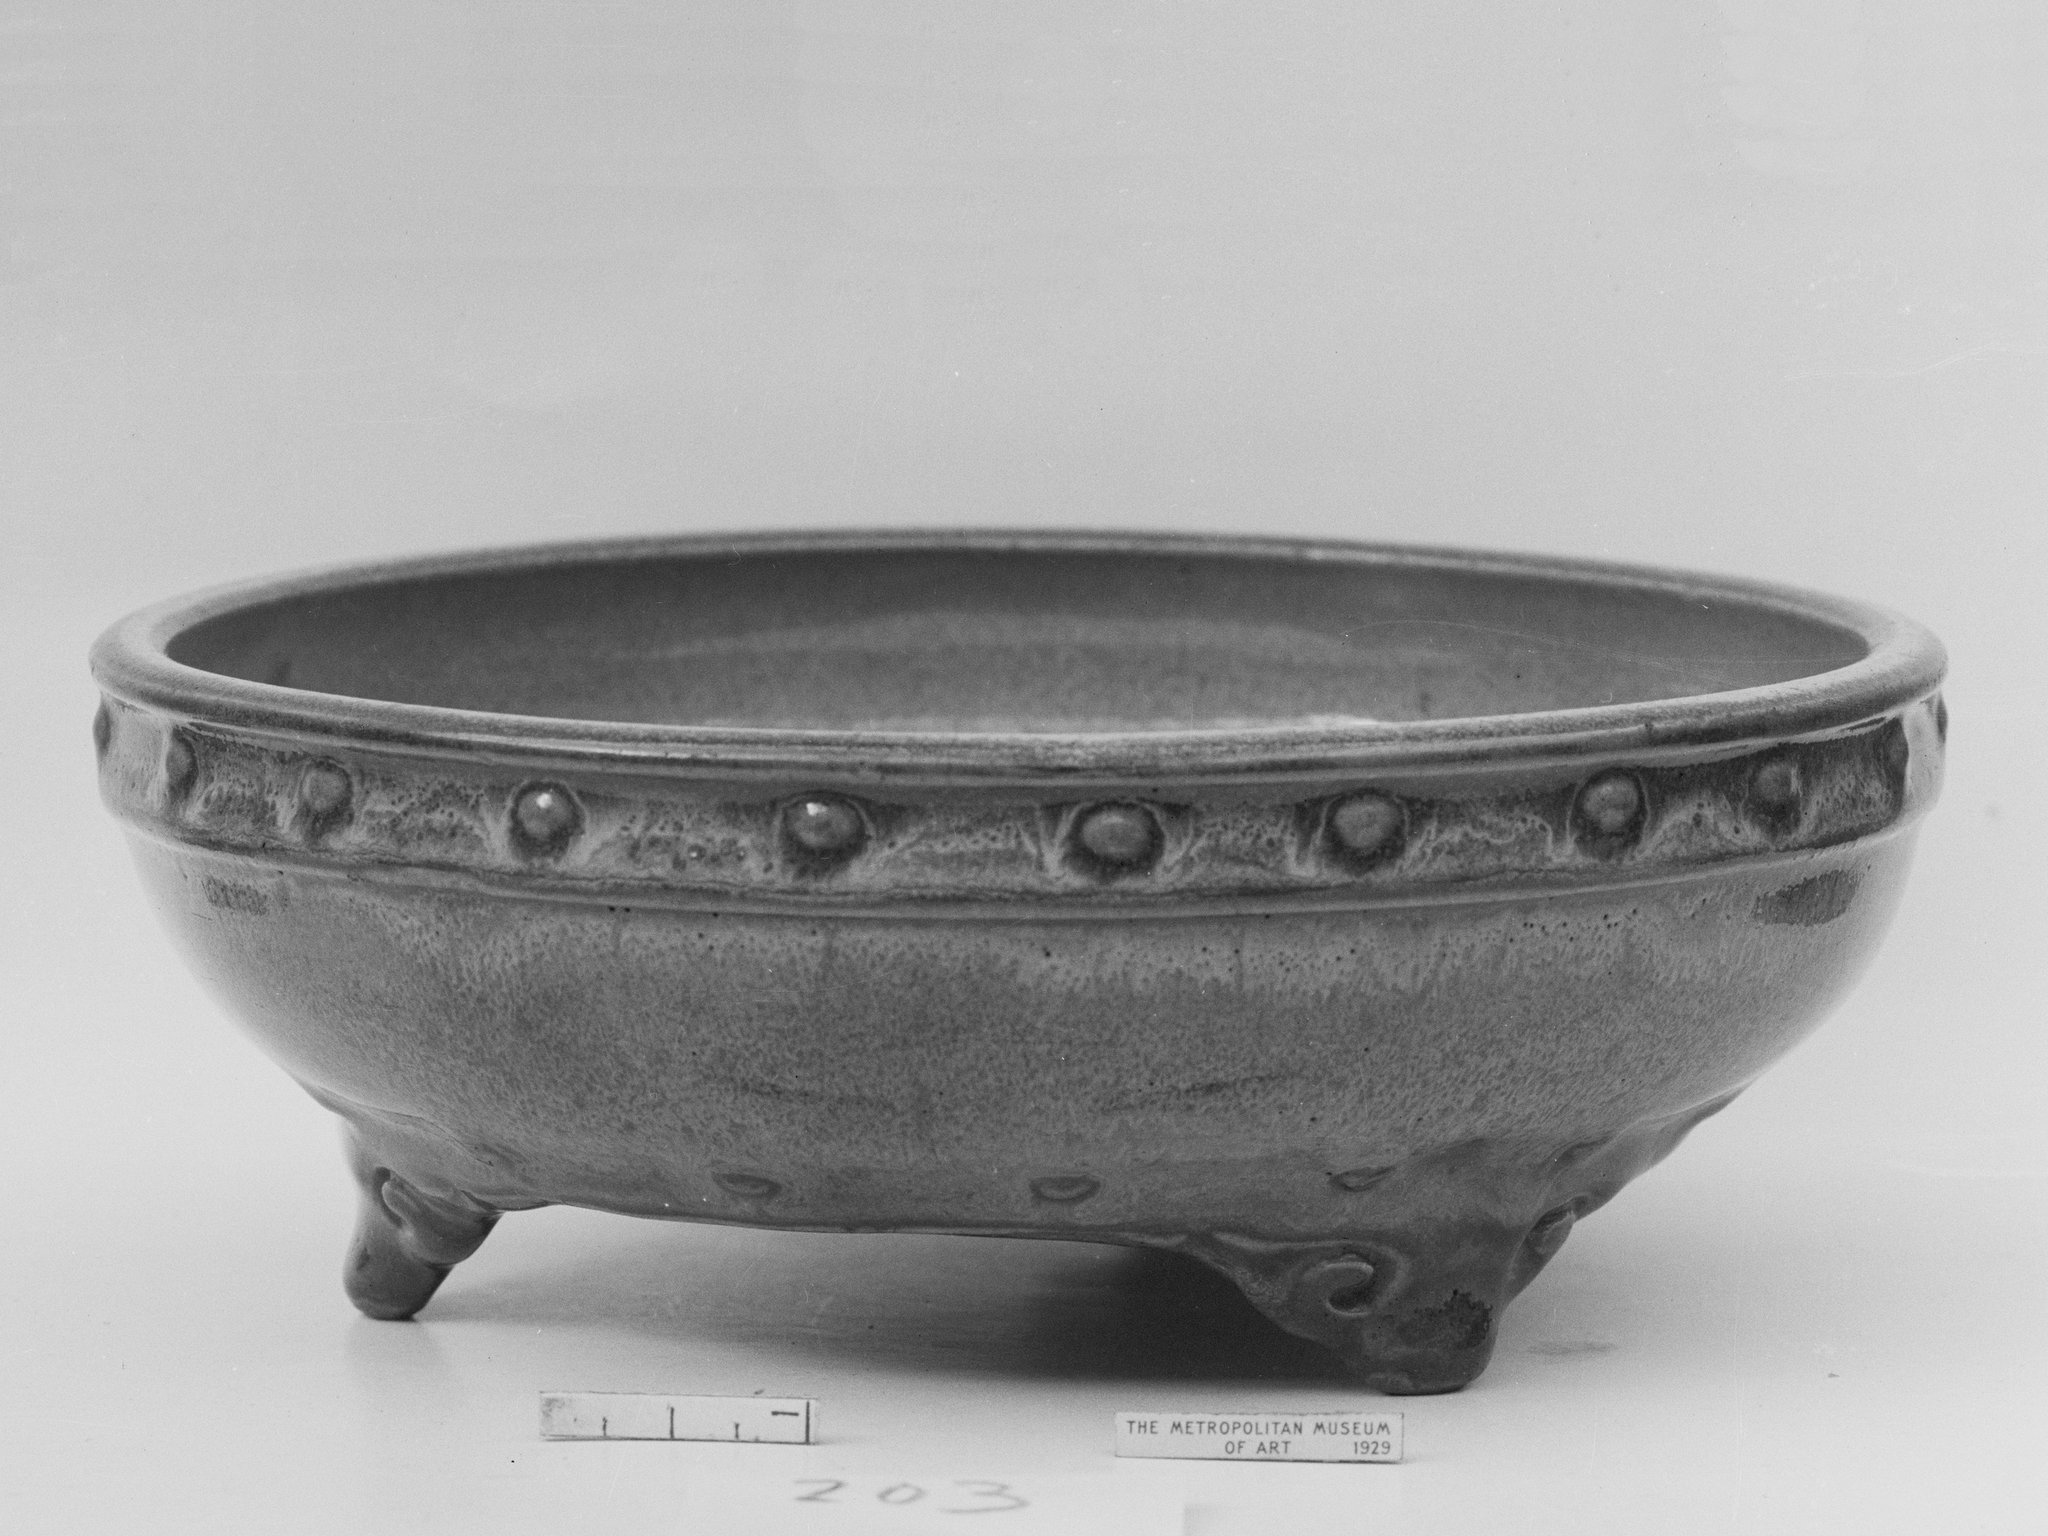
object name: bowl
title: Bulb Bowl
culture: chinese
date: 1271-1368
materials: glaze, stoneware